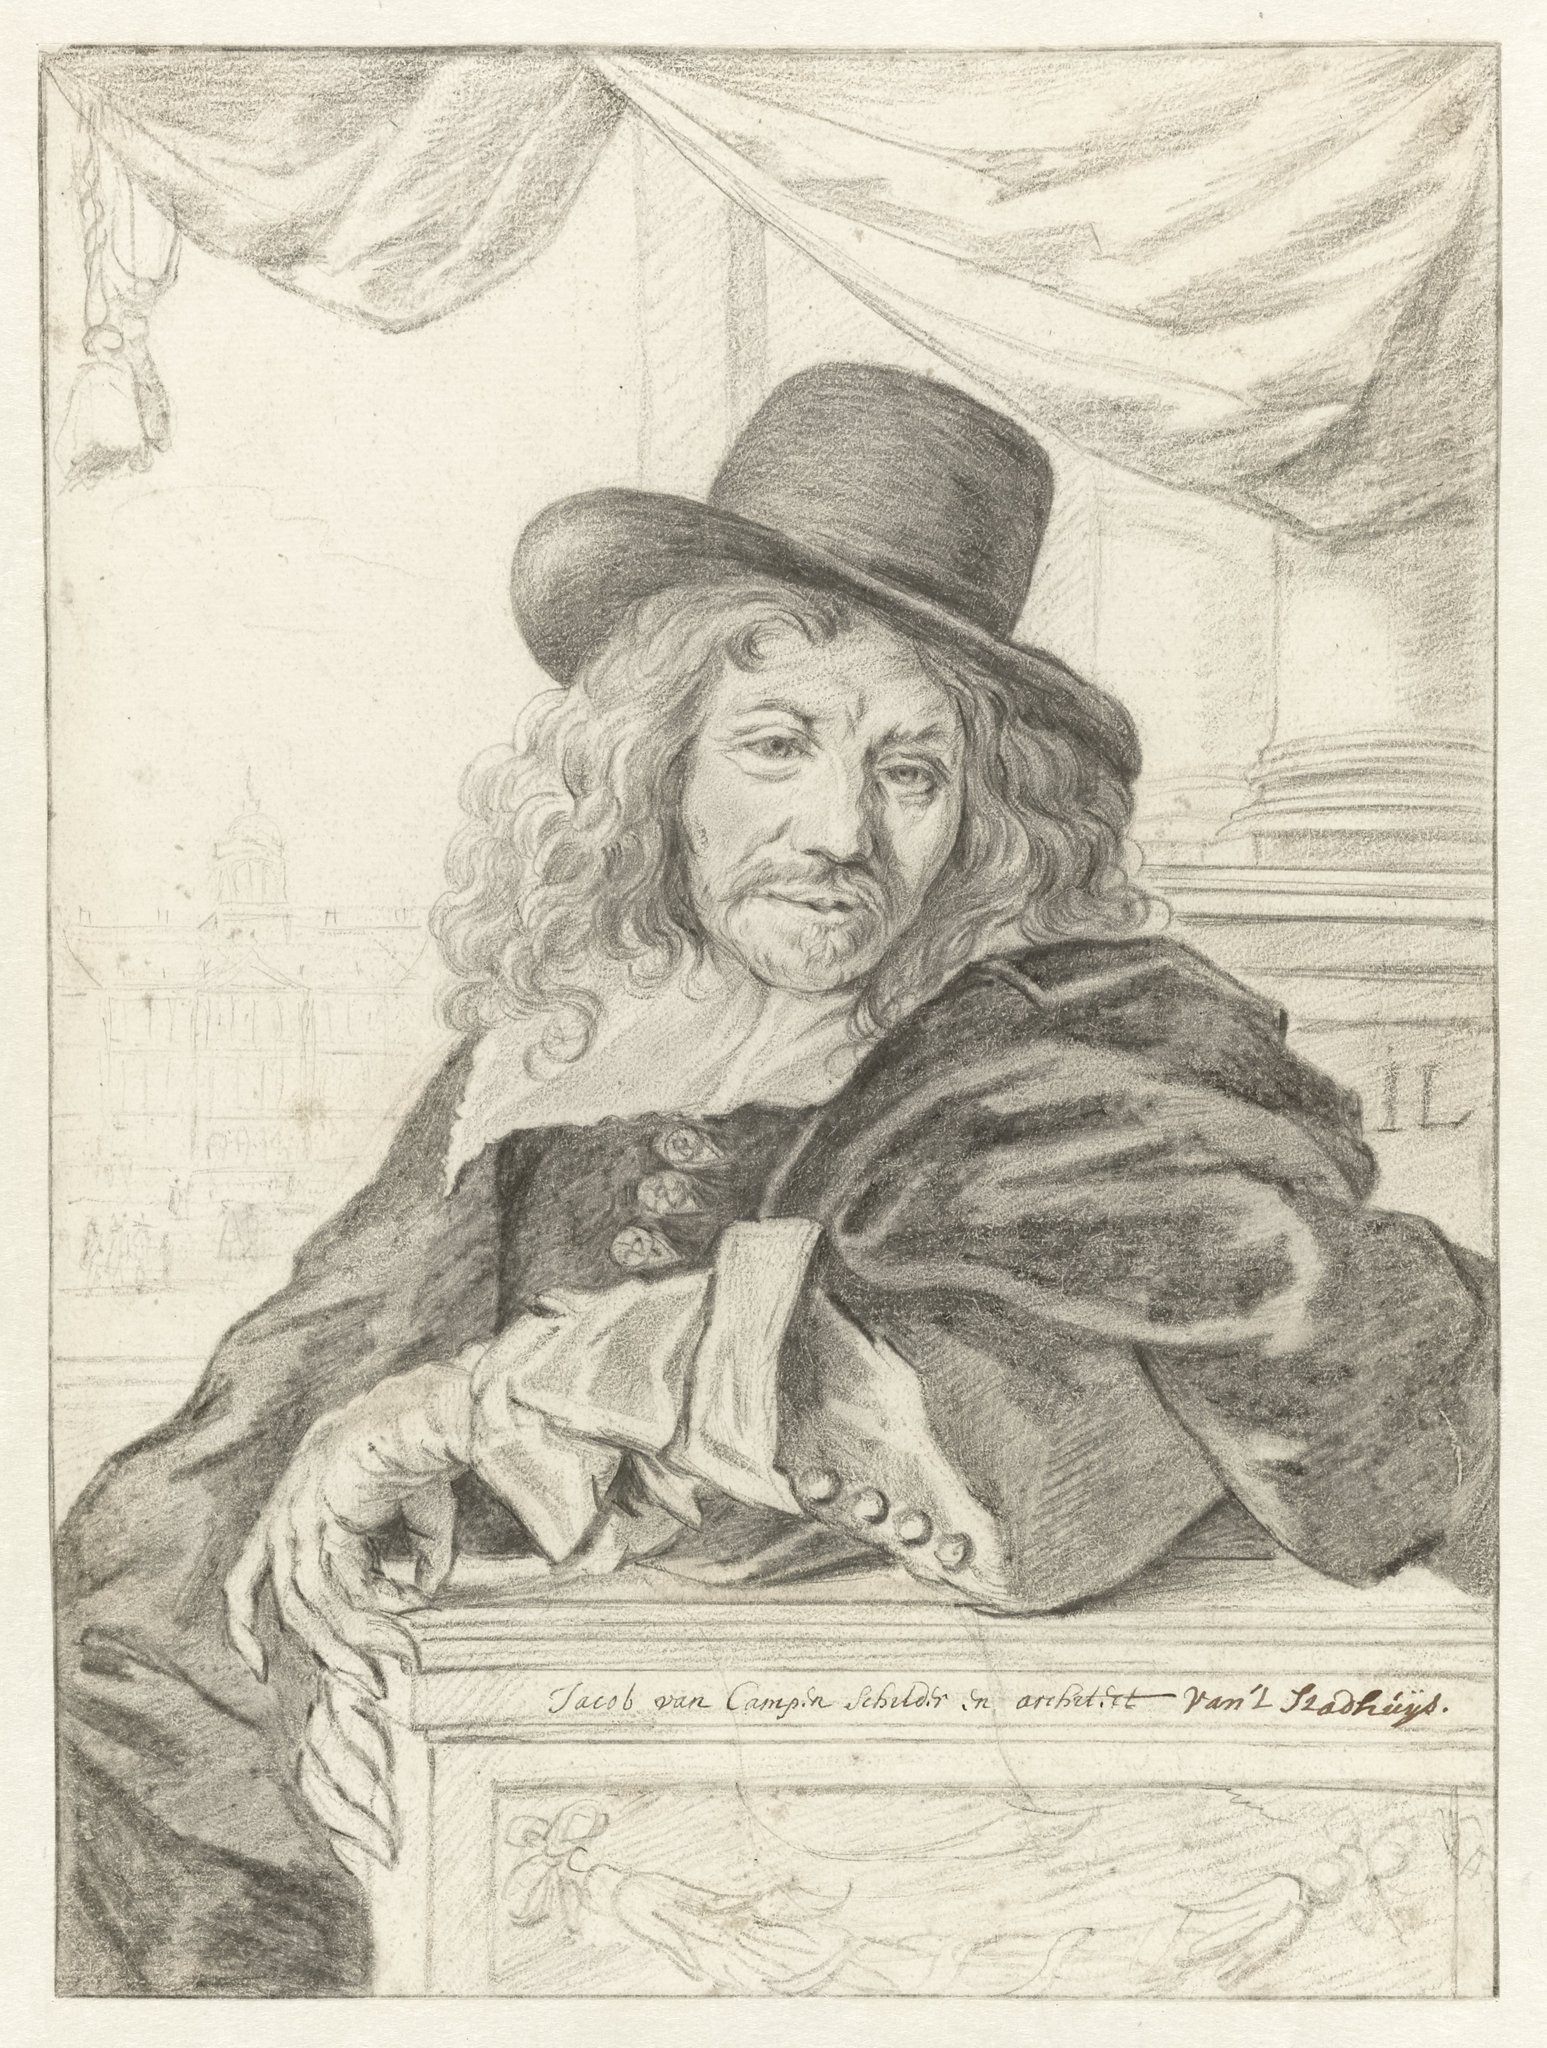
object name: drawing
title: Portret van Jacob van Campen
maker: Anonymous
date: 1661-1700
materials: chalk, paper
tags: haarlem, print maker, draughtsman, jacob van campen, historical persons, portrait, self-portrait of architect, portrait, self-portrait of painter, portrait, self-portrait of artist